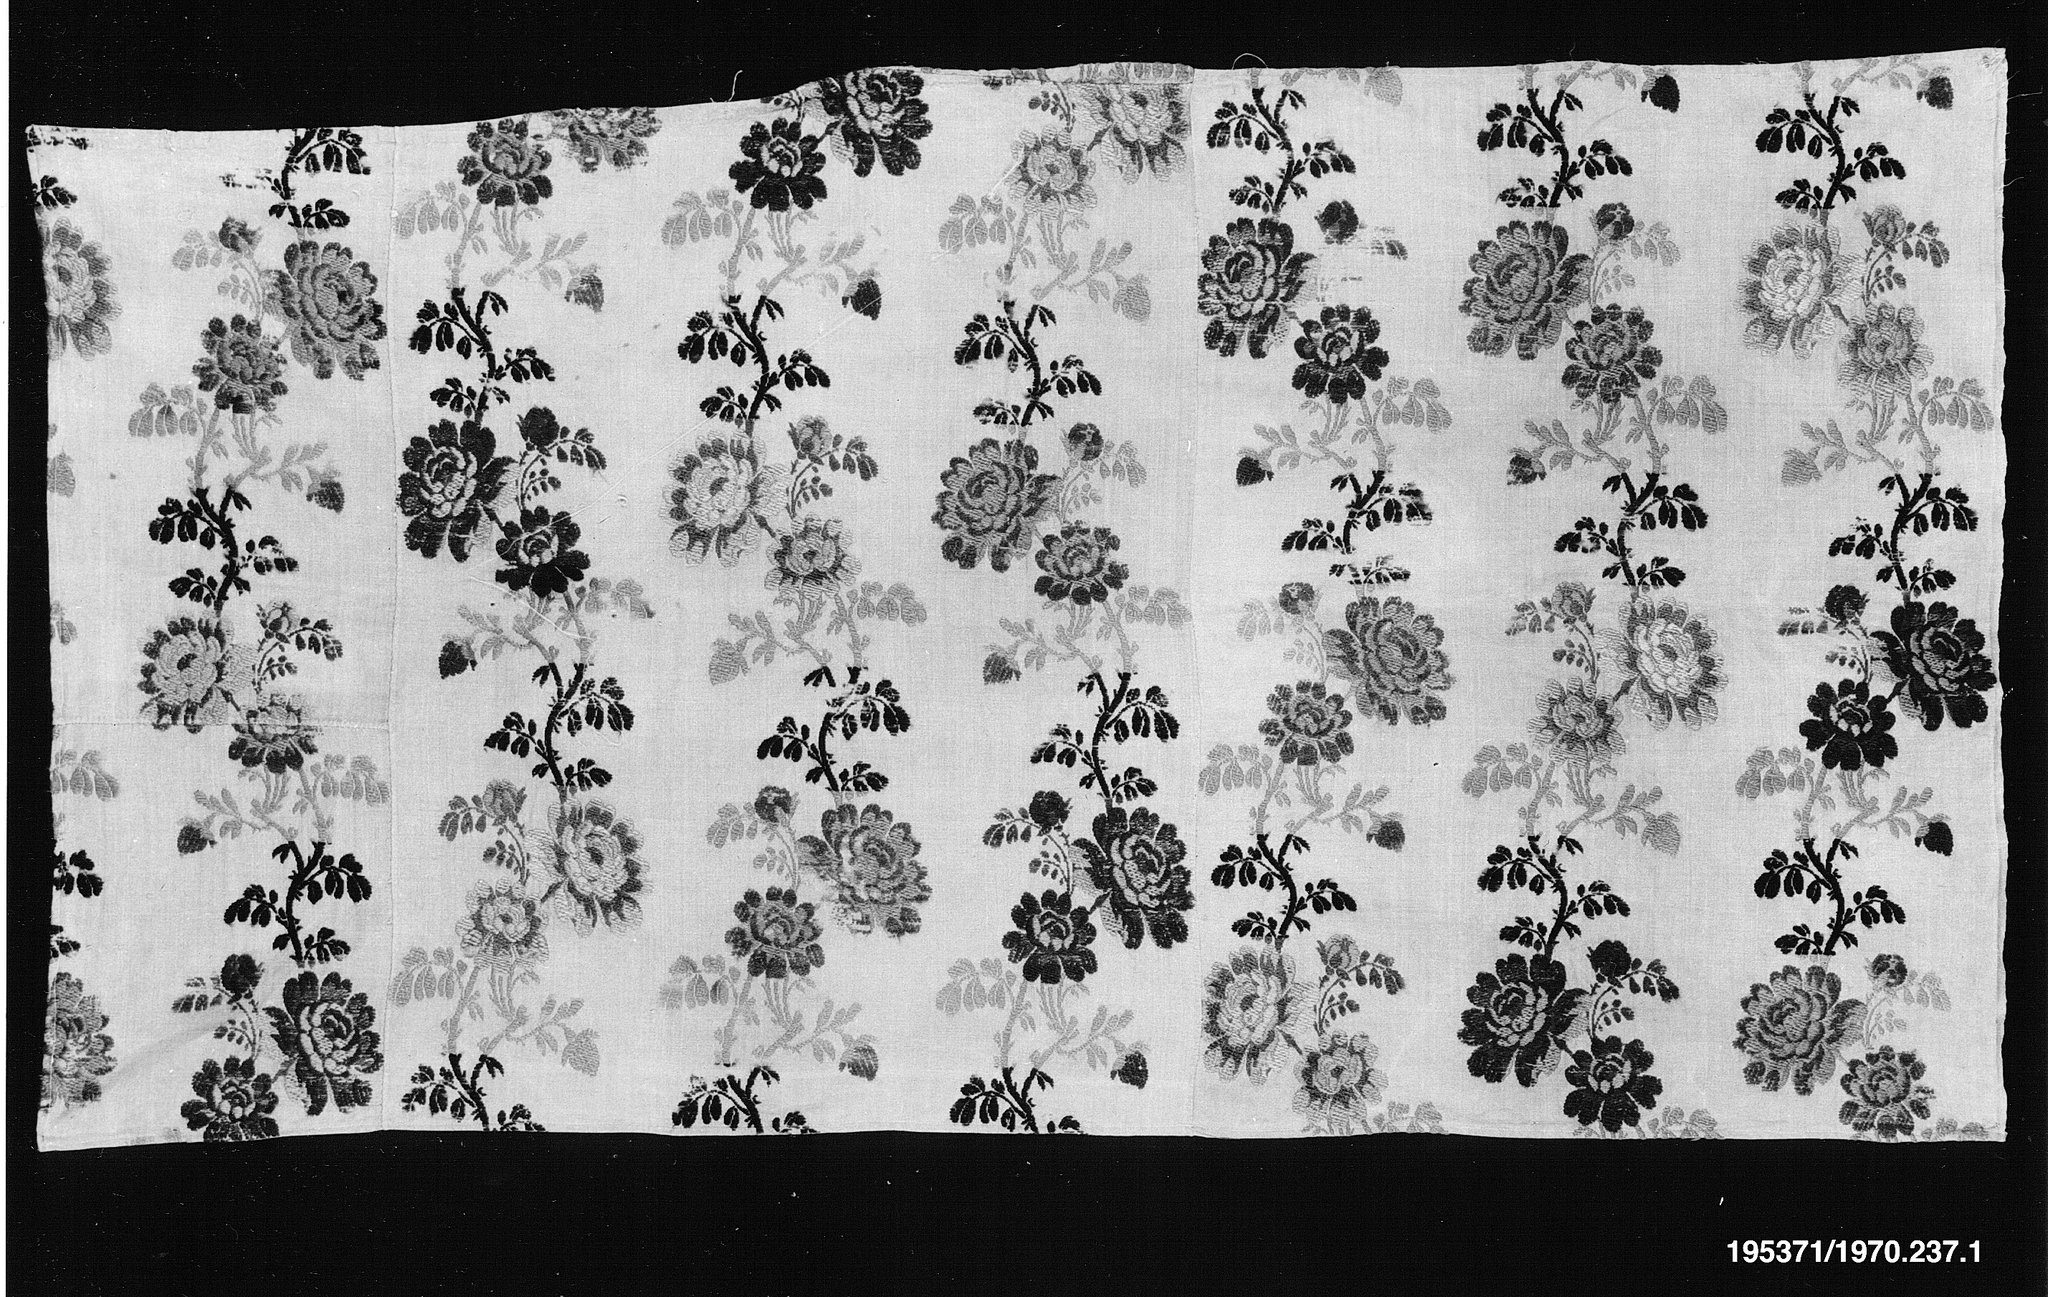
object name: panel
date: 1701-1800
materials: cotton, linen, wool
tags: flowers